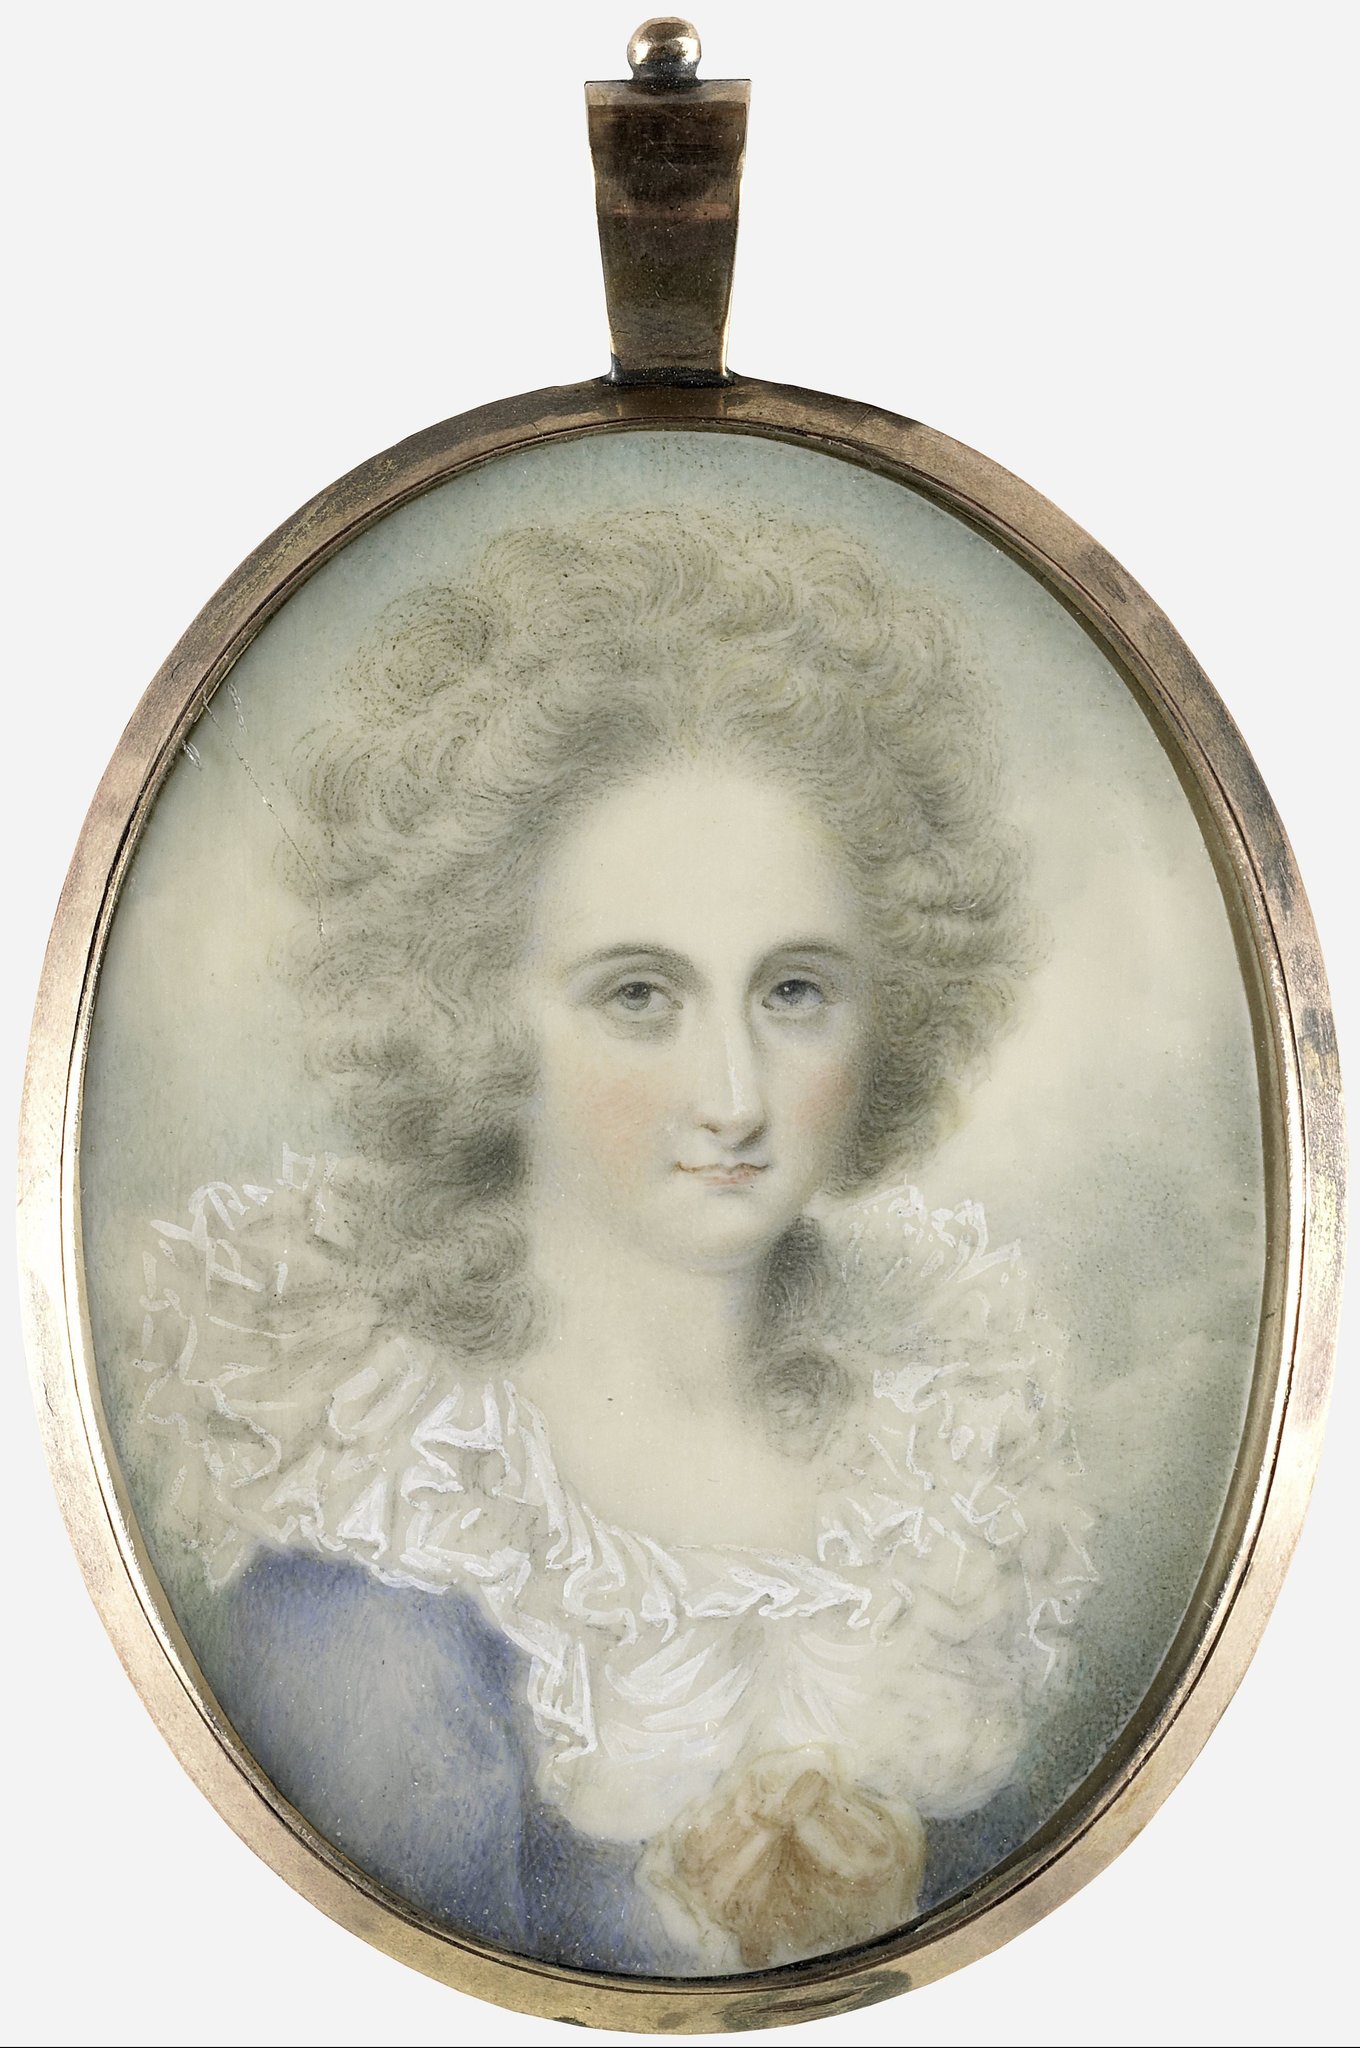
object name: painting, miniature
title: Portret van een vrouw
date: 1780-1799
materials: glass, gold thread, hair, ivory, metal, pearl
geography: england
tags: historical persons not known by name - bb - woman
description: Portret van een vrouw. Buste, aanziend. Op de boezem een oranje roos of strik. Onderdeel van de collectie portretminiaturen.